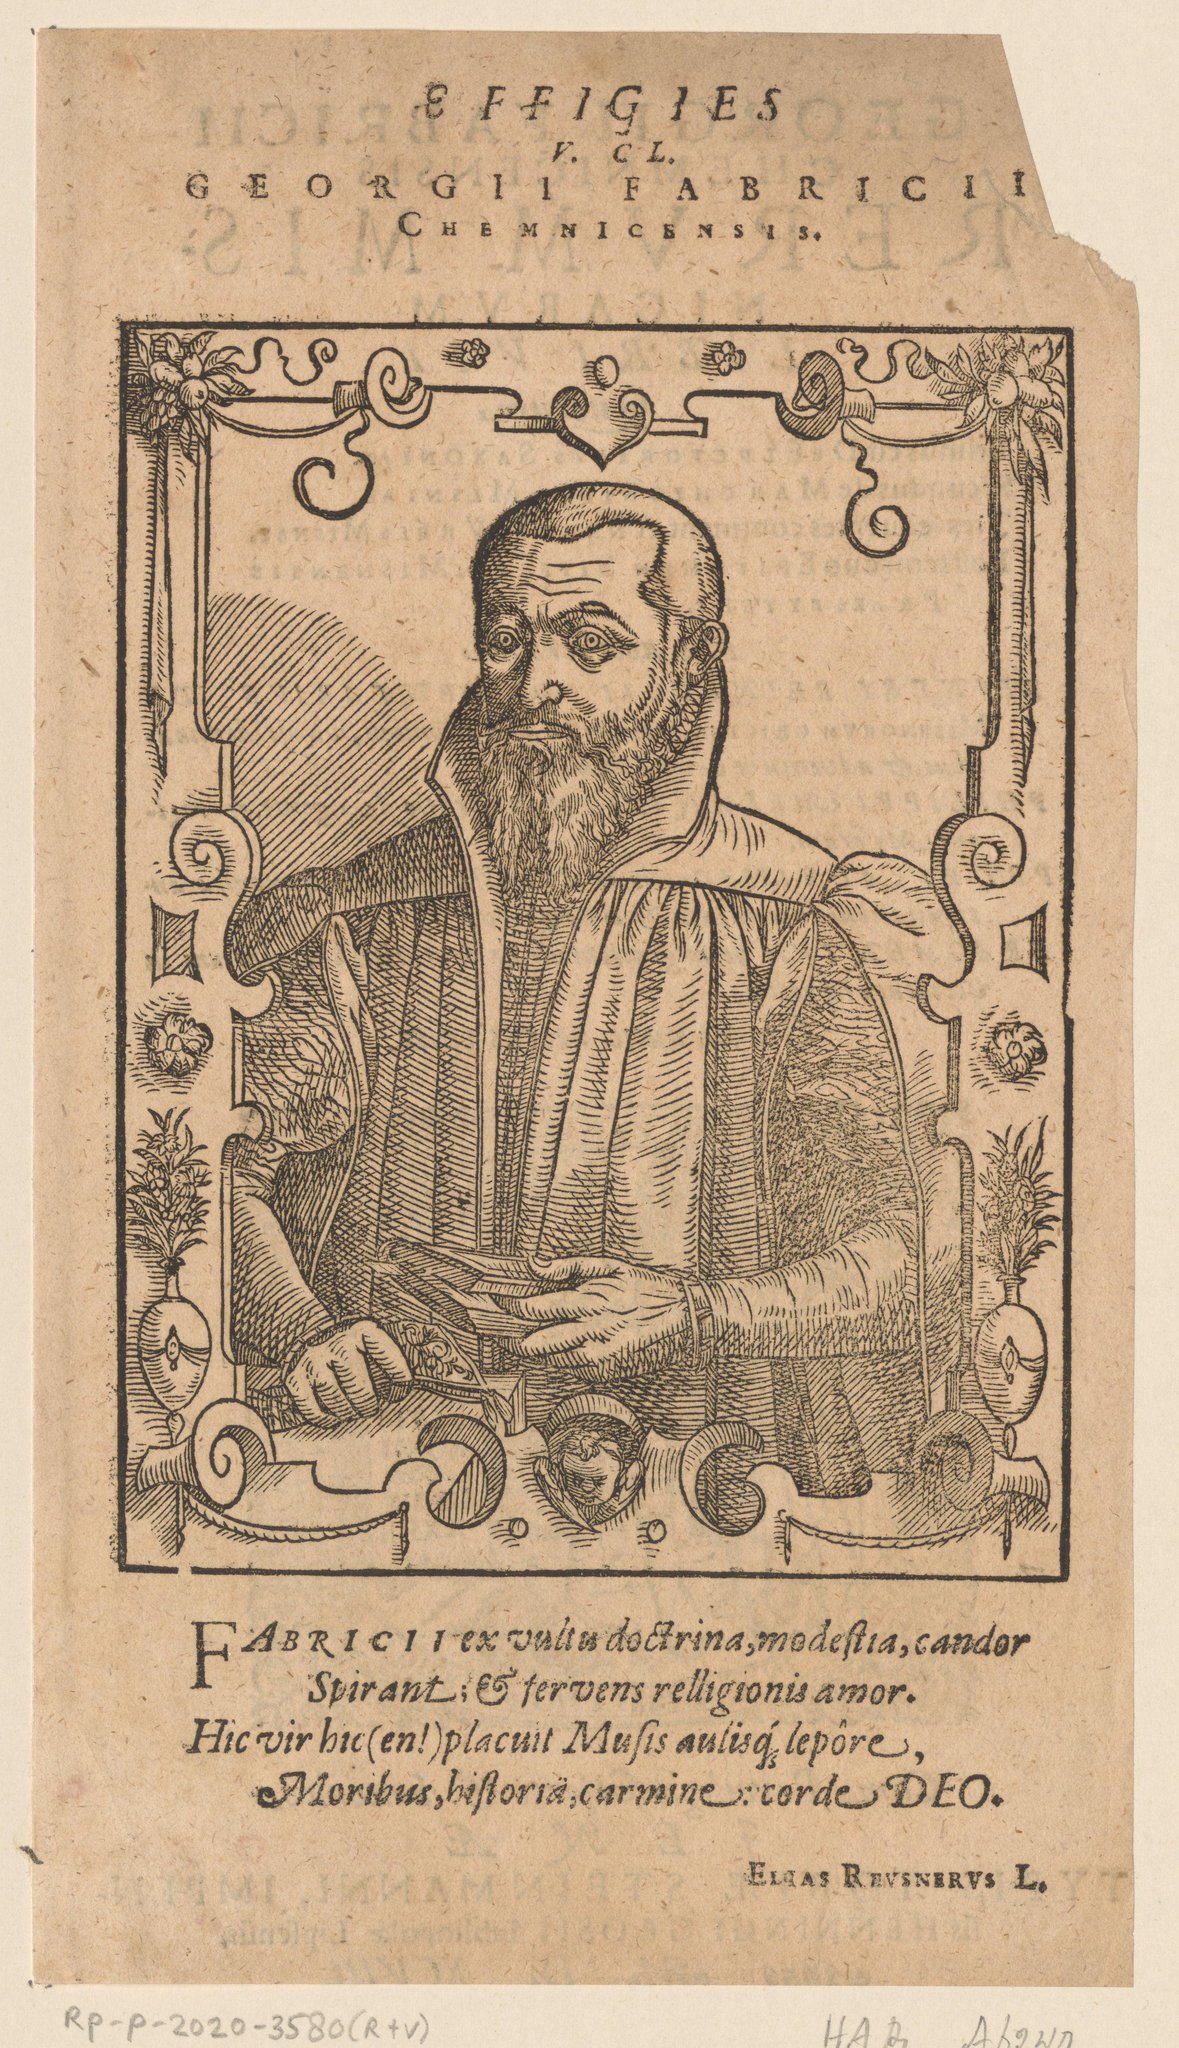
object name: book illustration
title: Portret van Georg Fabricius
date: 1598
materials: paper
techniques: letterpress printing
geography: germany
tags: chemnitz, georgius fabricius (1516-1571), fruits and vegetables ~ ornament, historical persons, portrait of a writer, book, vignette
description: Prent uit: Fabricius, Georg. Rerum Misnicarum Libri VII. Leipzig: Henning Grosse I, 1598.